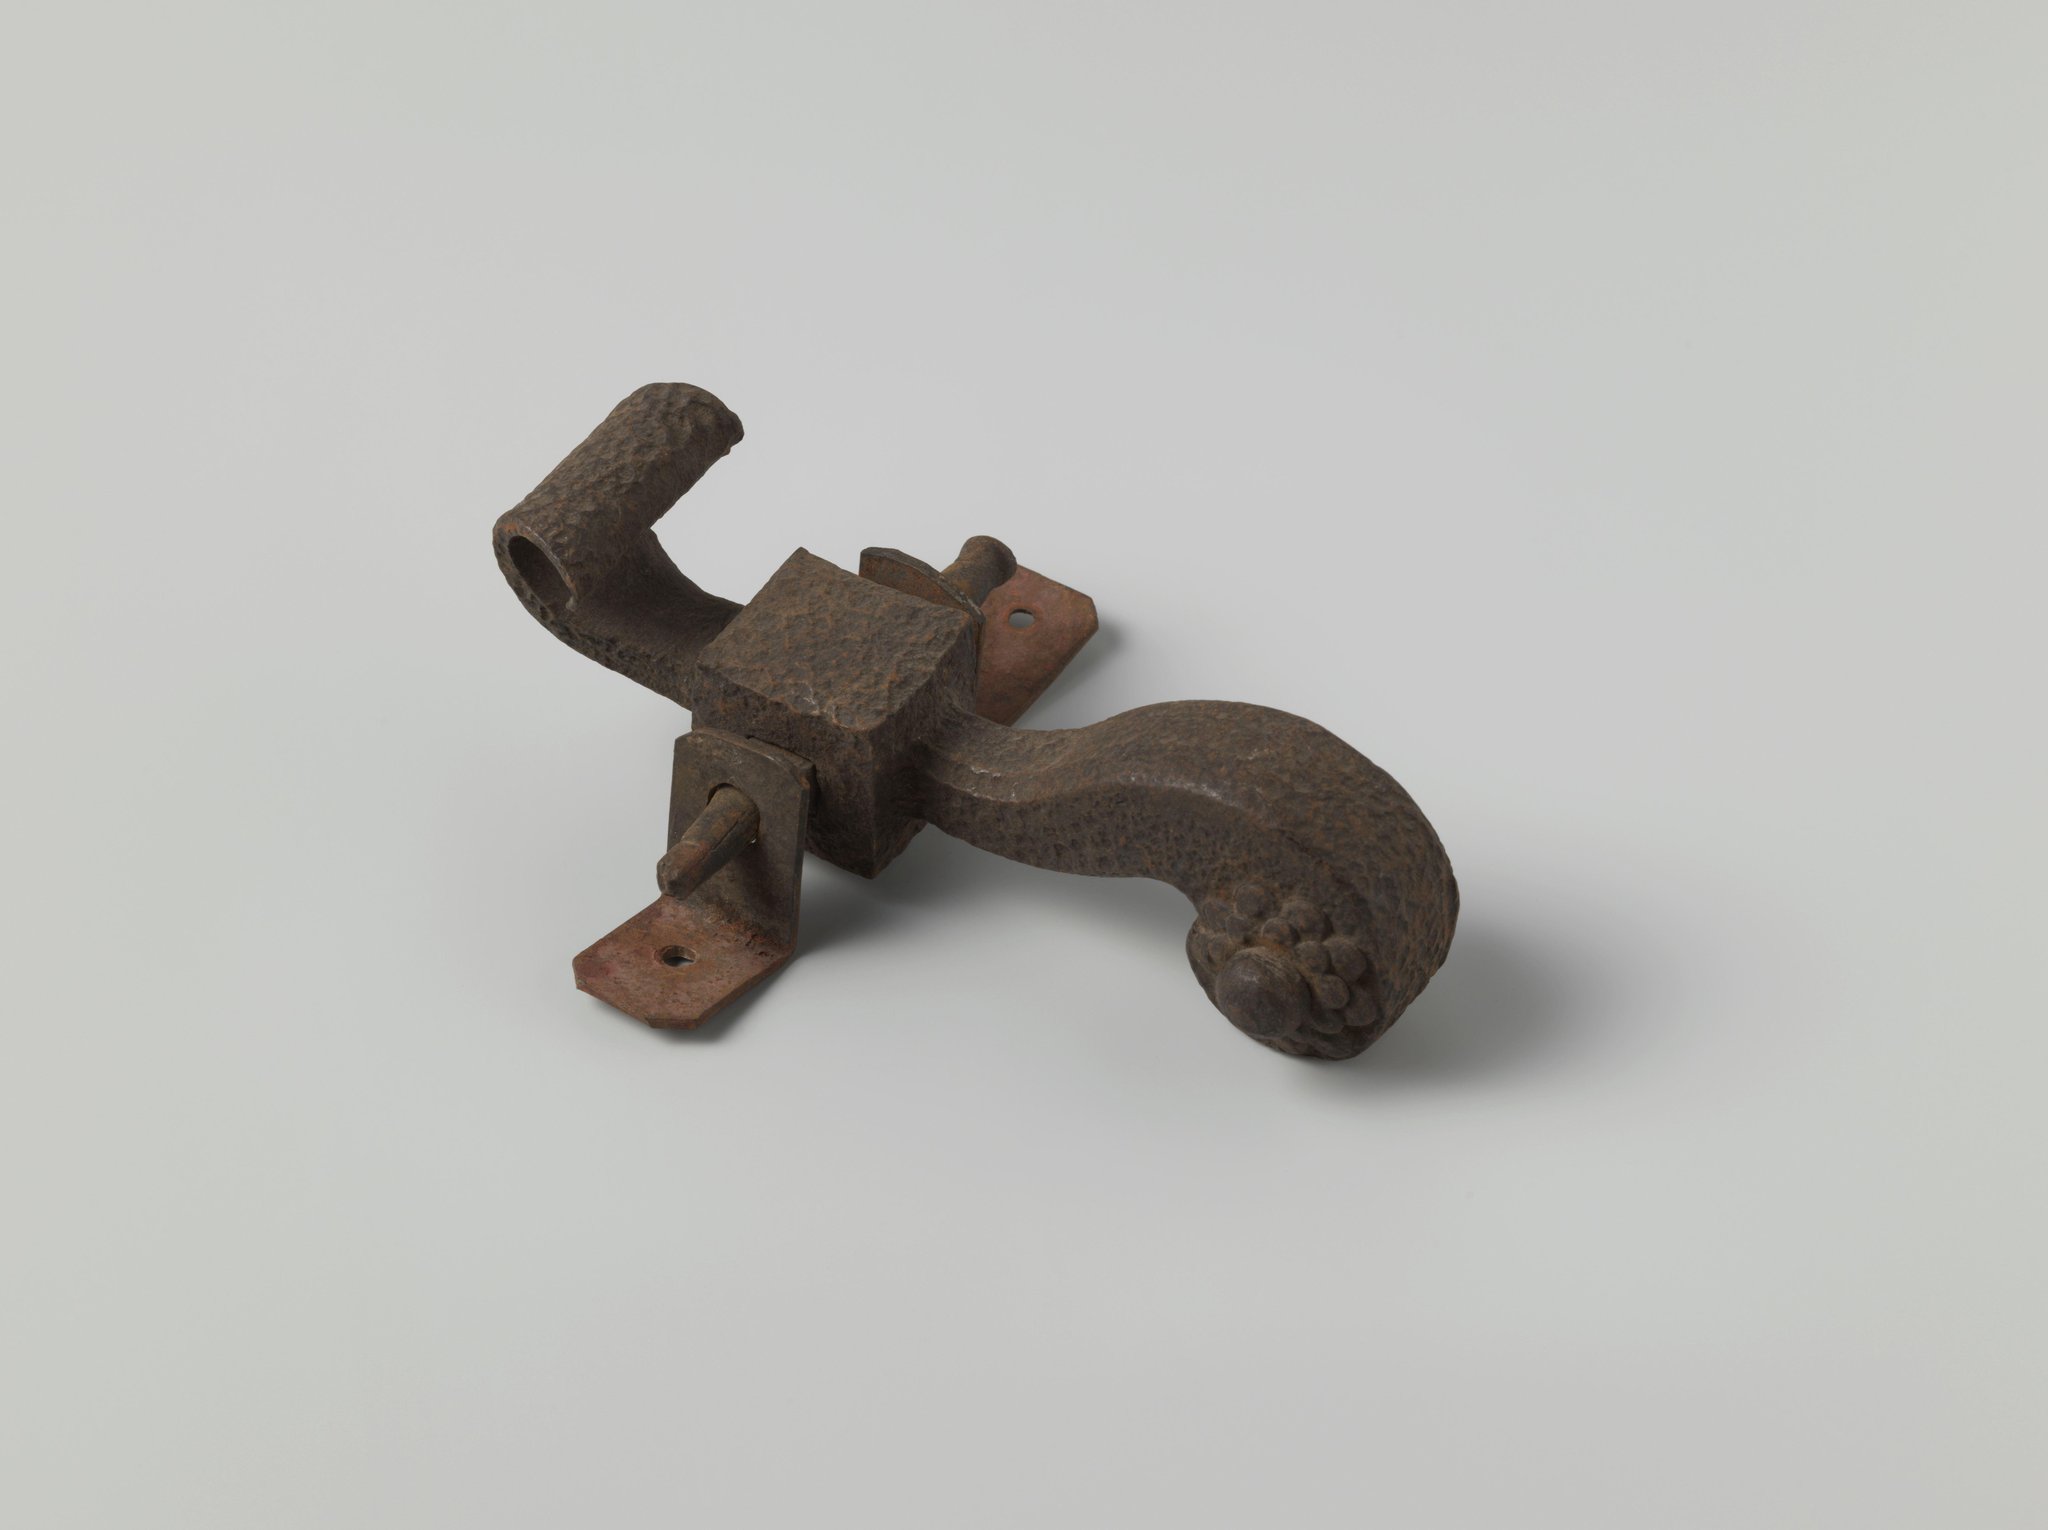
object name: door knocker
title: Deurklopper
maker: Anonymous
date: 1600-1699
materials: iron